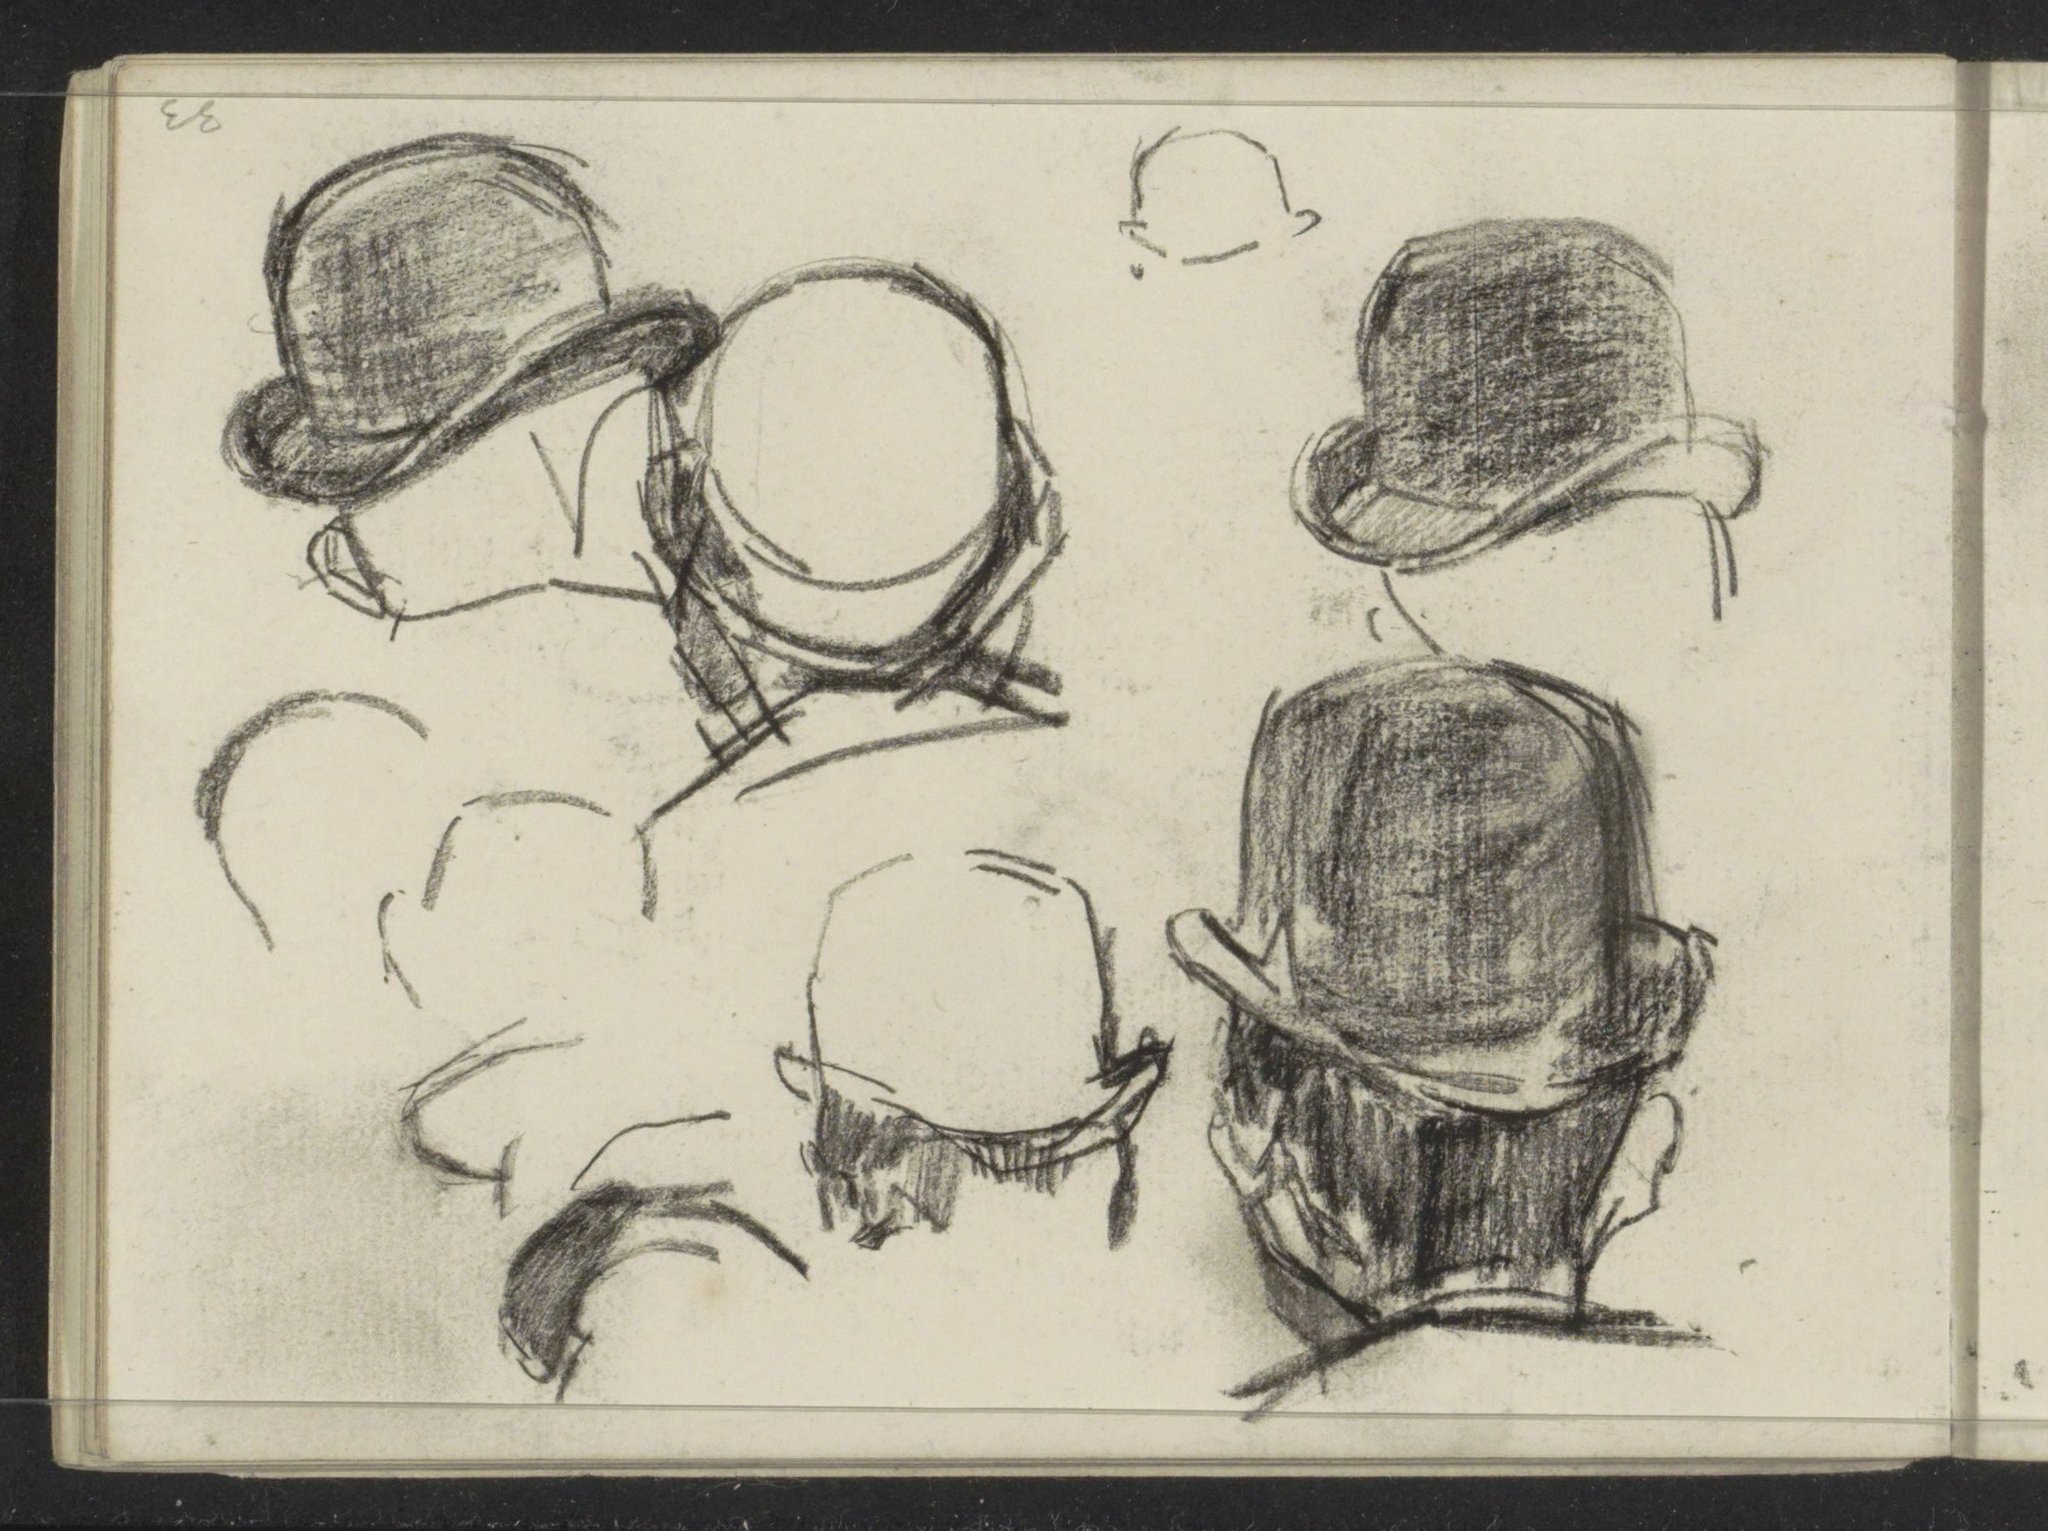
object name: sketchbook leaf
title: Mannenhoofden met hoeden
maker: isaac israels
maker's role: draughtsman, painter, print maker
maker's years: 1865-1934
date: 1886-1934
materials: chalk, paper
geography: amsterdam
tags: head (human), head-gear: hat (+ men's clothes)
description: Blad 26 verso uit schetsboek LXIV met 29 bladen.